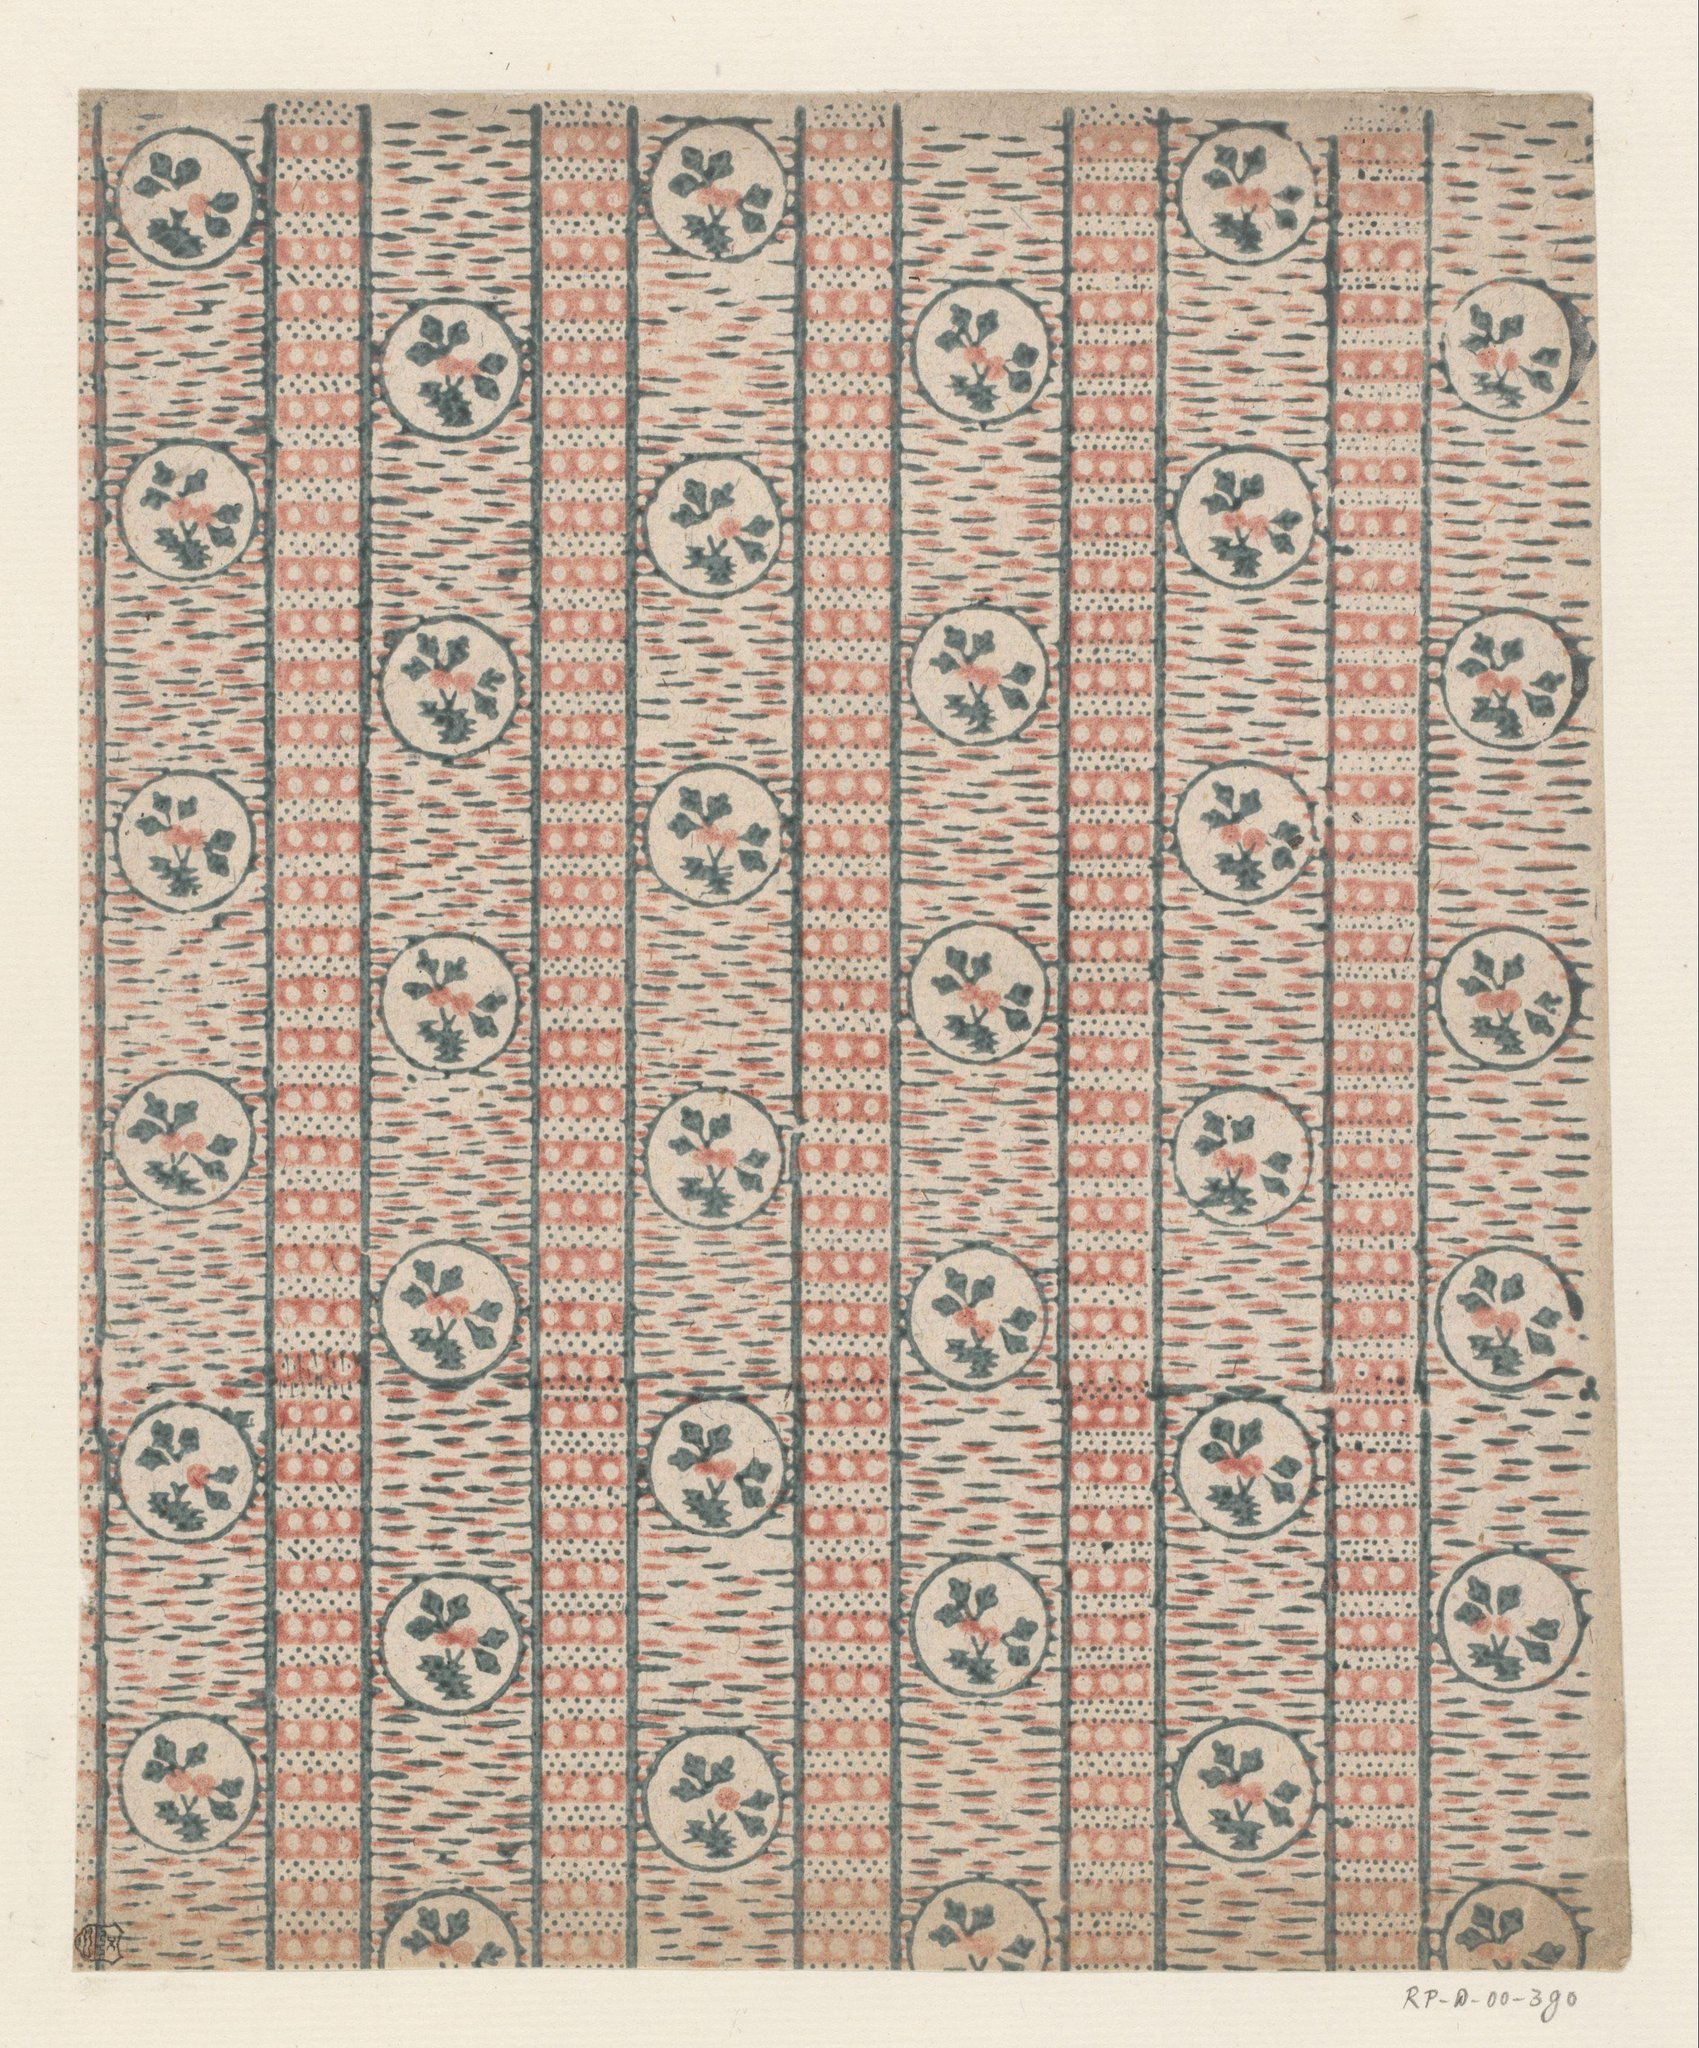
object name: printed paper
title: Blad met banenpatroon van rondje met tak met twee vruchten in sierlijst met stippen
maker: Anonymous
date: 1700-1850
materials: paper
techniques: printing block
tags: ornament derived from plant forms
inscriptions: collector's mark: Lugt 2228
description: Blad met banenpatroon van takje met twee vruchtjes in cirkel omgeven door streepjes en van motief met drie cirkels in balkje met punten.